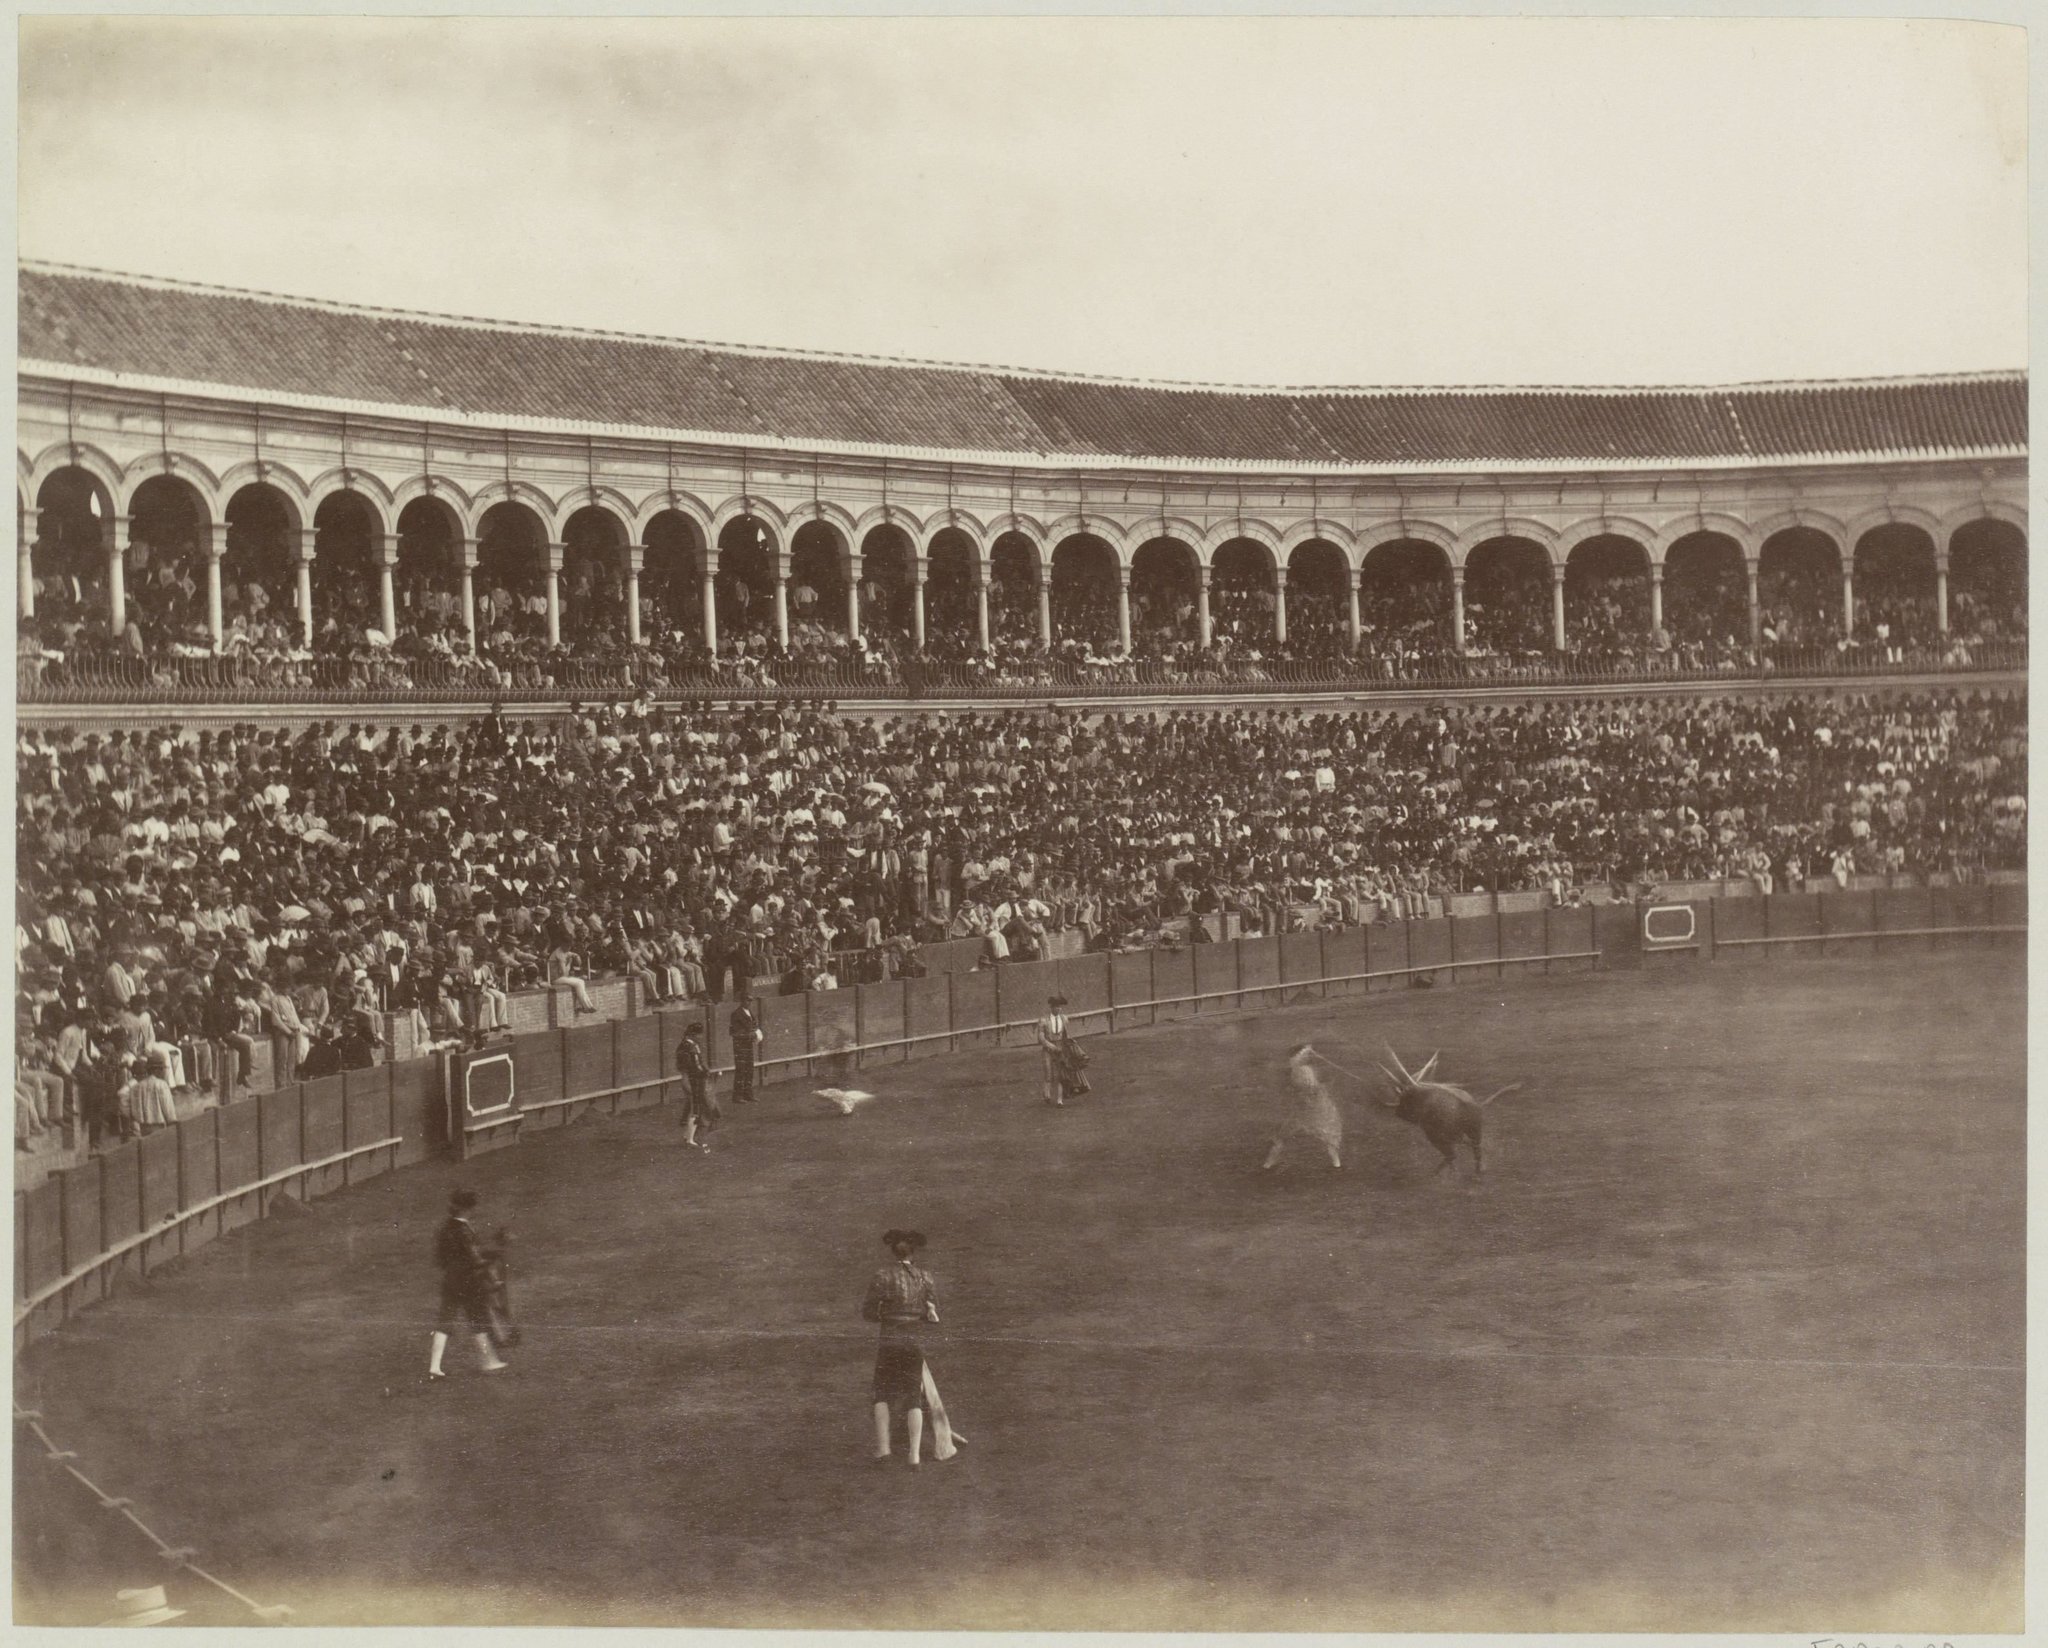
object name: photograph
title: Stierengevecht in de Plaza de Toros de la Real Maestranza de Caballería de Sevilla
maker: Anonymous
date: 1860-1880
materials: cardboard, paper, photographic support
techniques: albumen print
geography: spain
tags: bullfight, grounds, fields and accomodations for sports, games and physical performances (+ out of doors (sports, games, etc.)), sevilla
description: Onderdeel van Reisalbum met foto's van bezienswaardigheden in Spanje en Marokko.